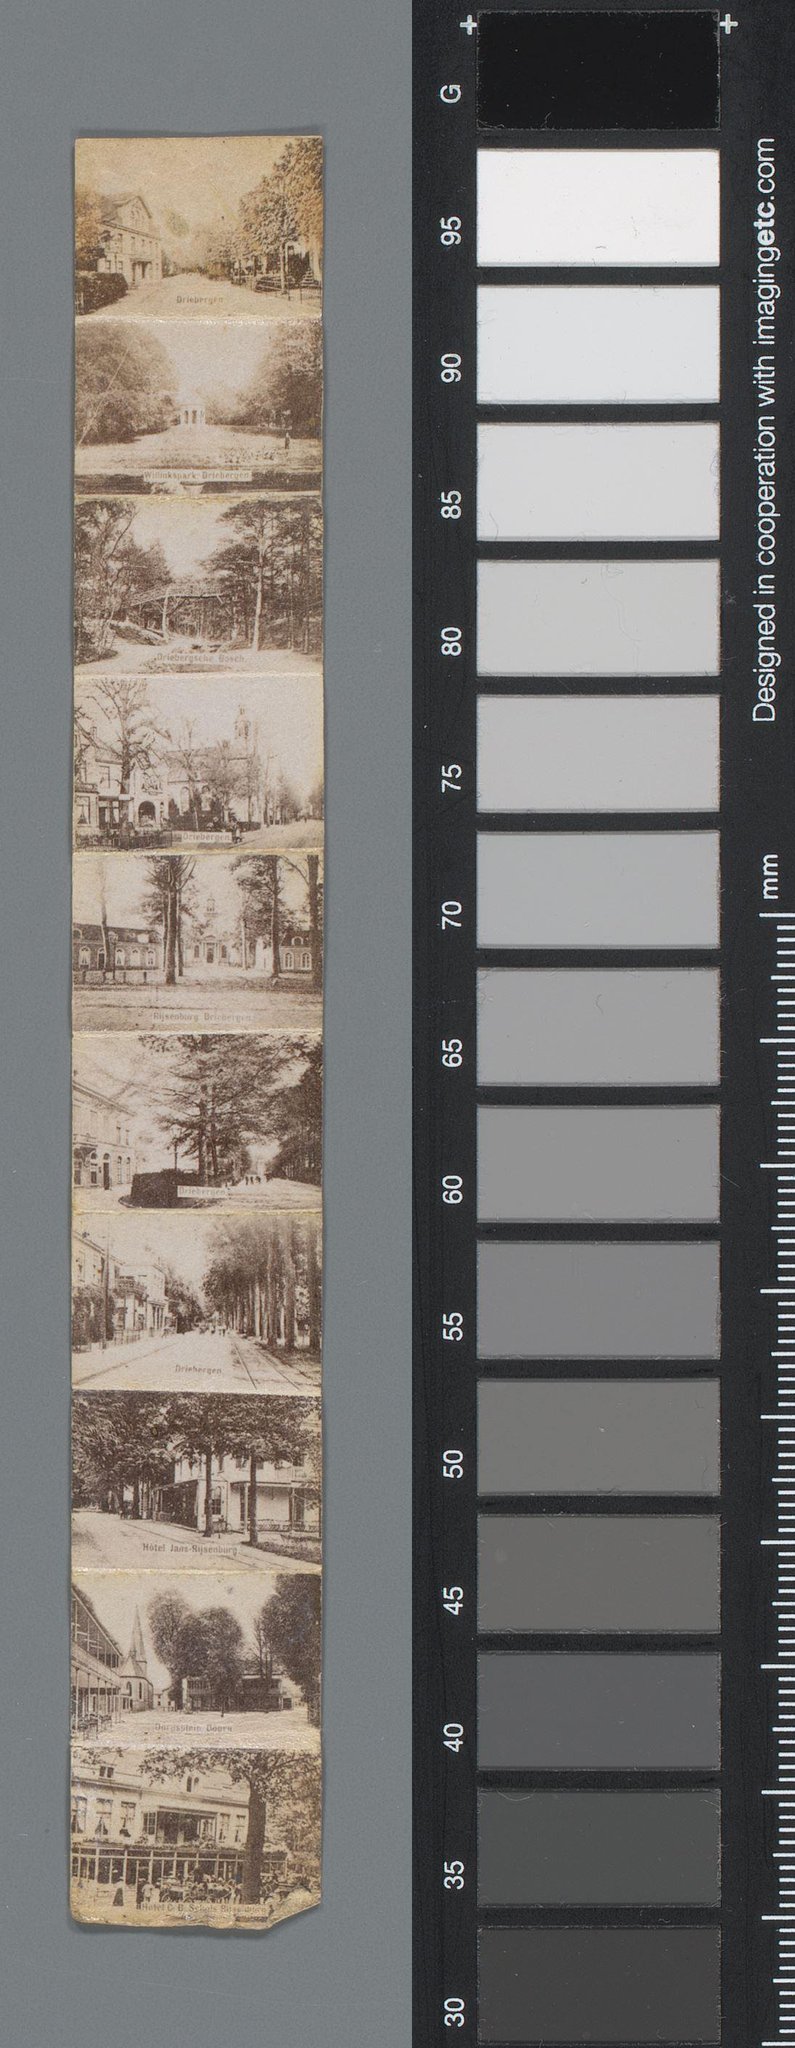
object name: photograph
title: Gezicht op een straat in Driebergen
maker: Anonymous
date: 1851-1900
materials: paper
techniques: albumen print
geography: driebergen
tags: street